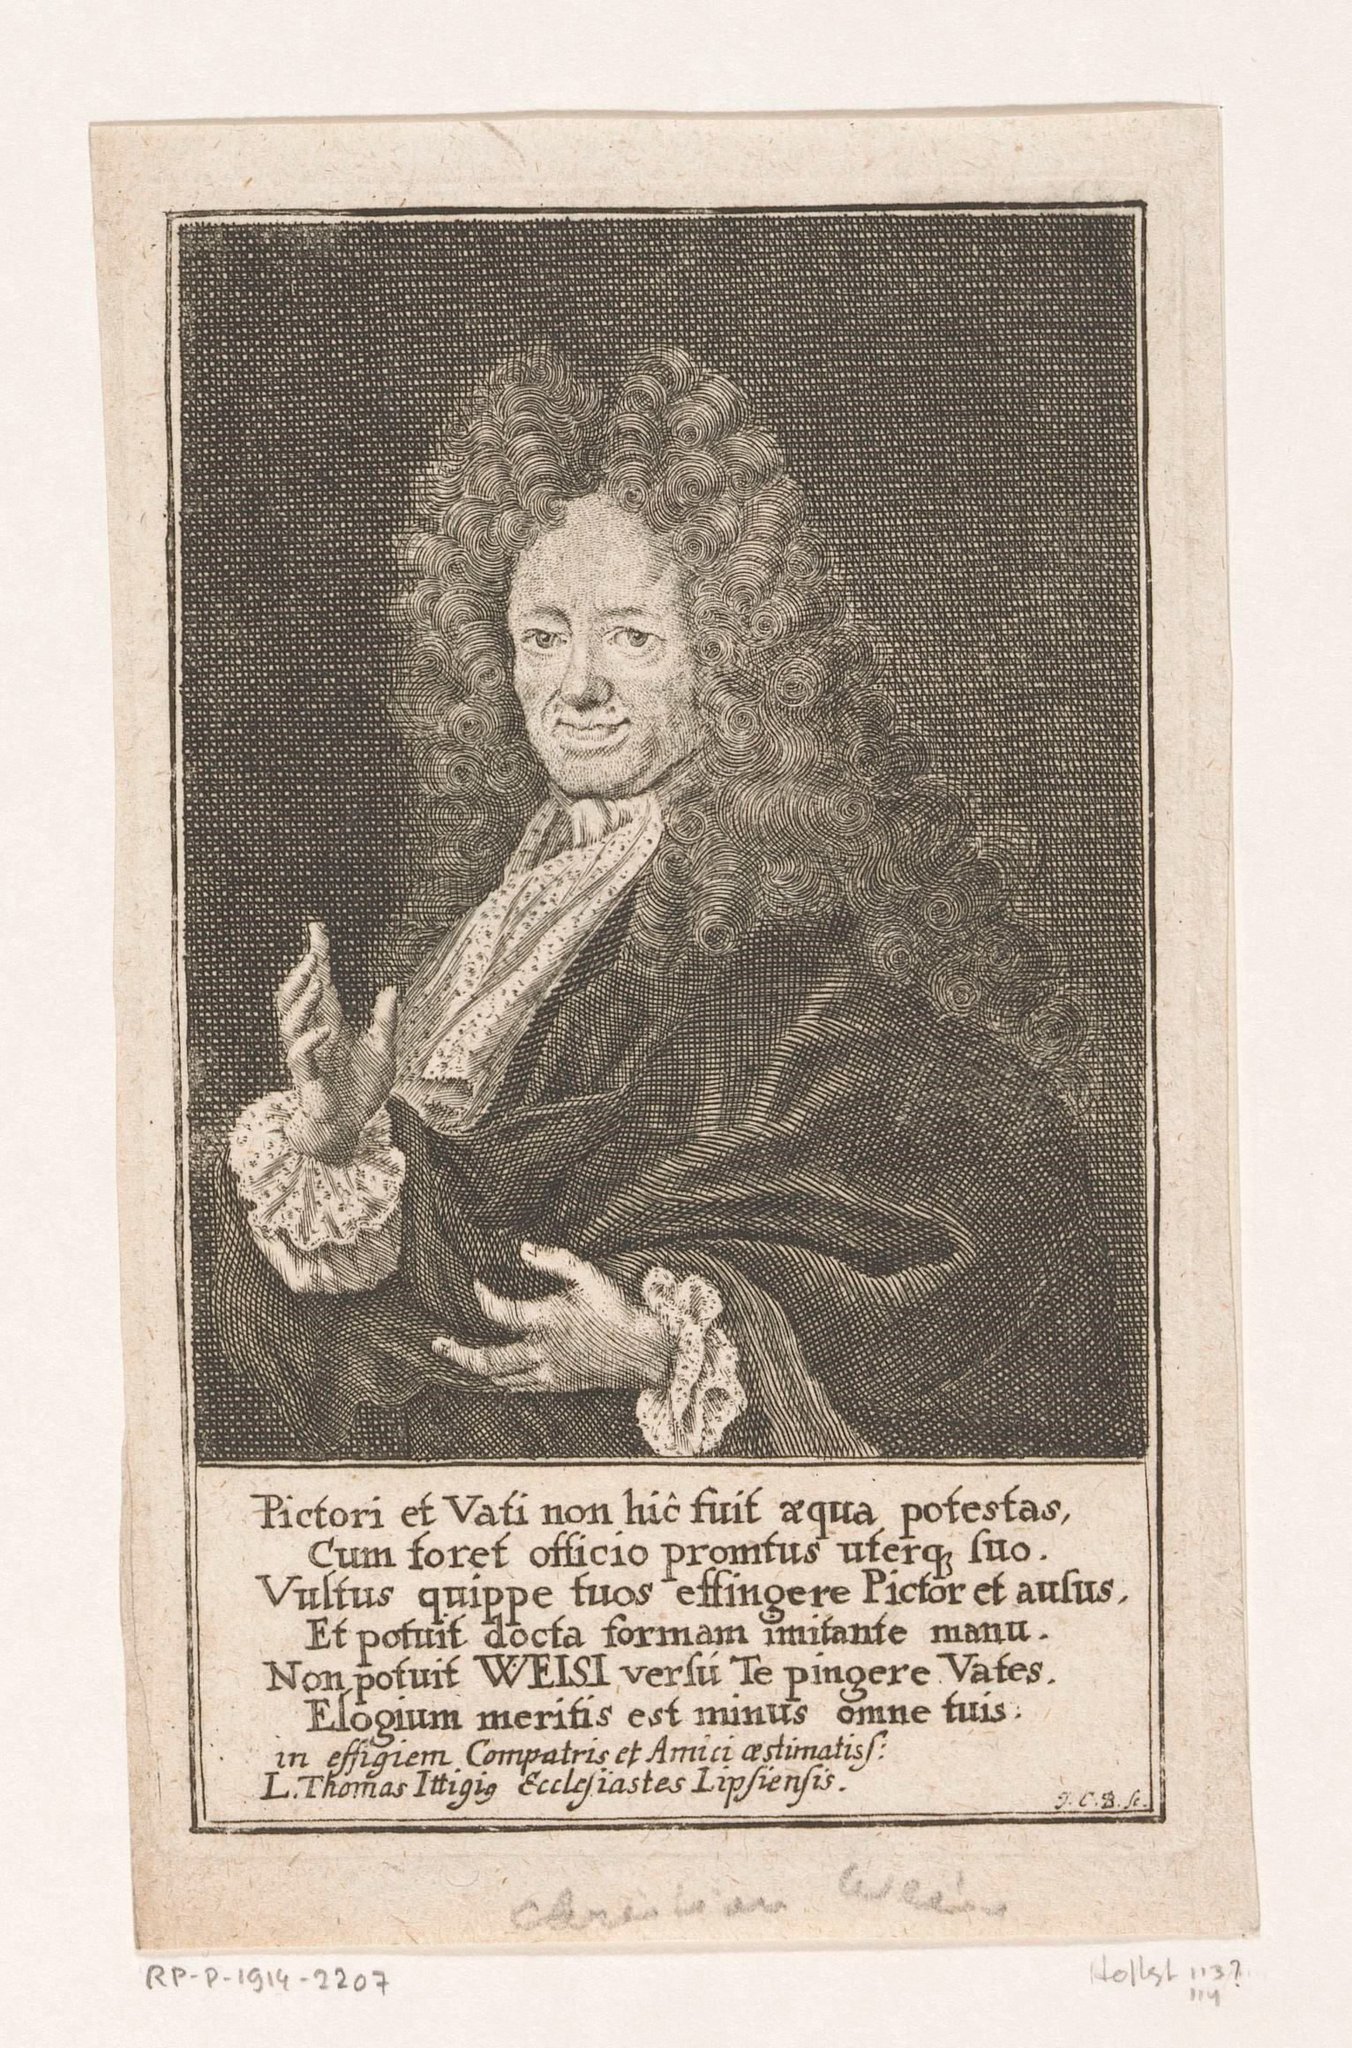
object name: print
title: Portret van Christian Weise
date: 1667-1709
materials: paper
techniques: engraving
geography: leipzig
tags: historical persons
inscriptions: collector's mark: Lugt 2228